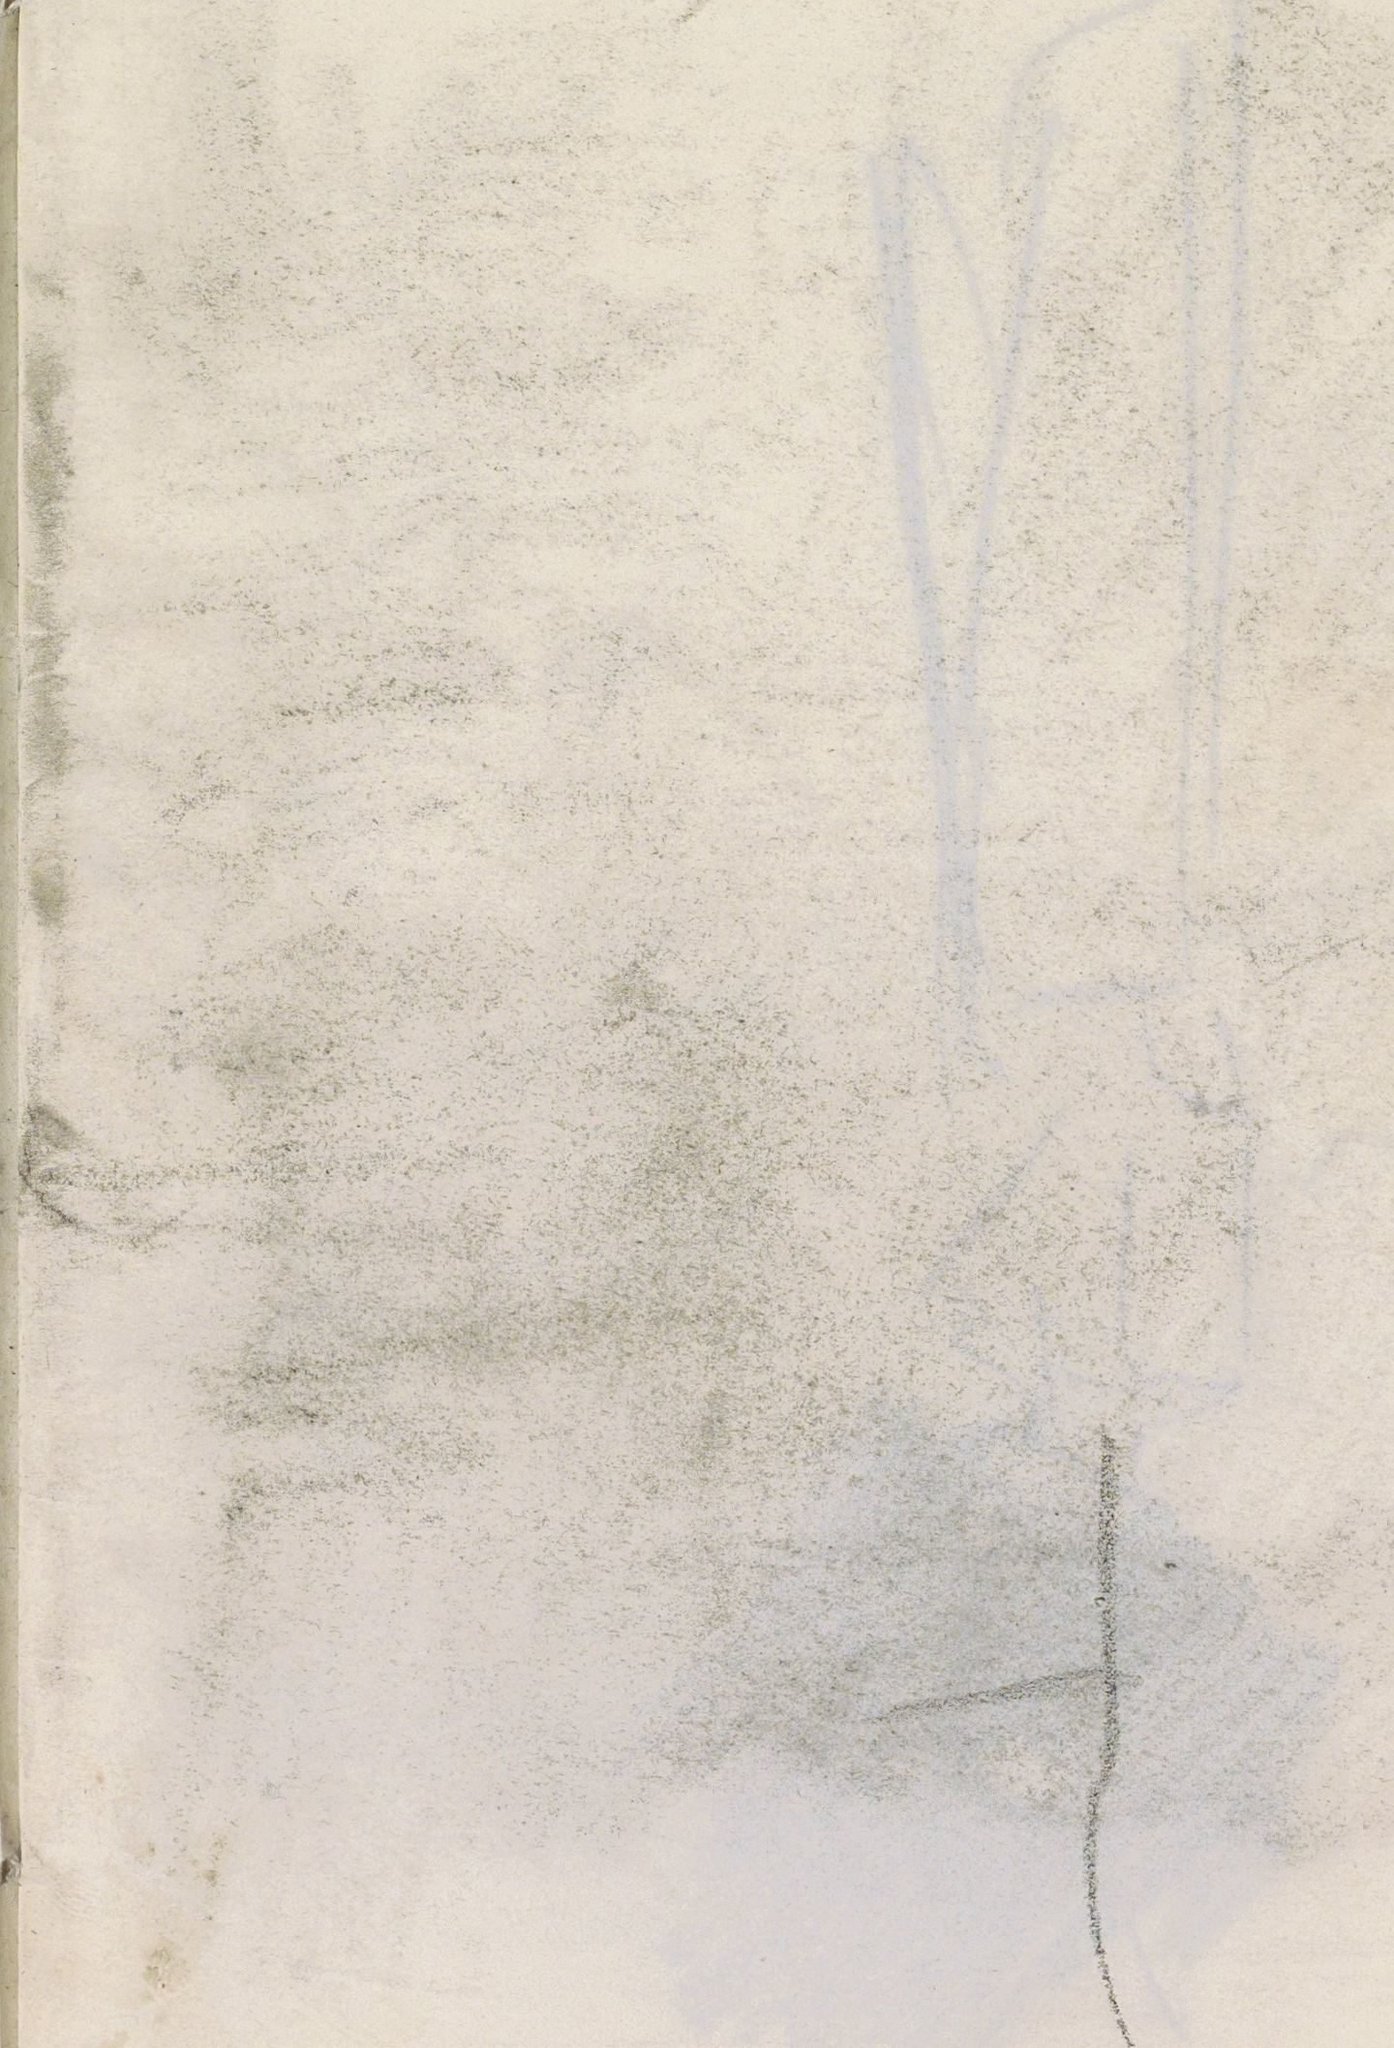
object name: sketchbook leaf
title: Studie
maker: isaac israels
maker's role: draughtsman, painter, print maker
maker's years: 1865-1934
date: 1875-1934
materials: chalk, paper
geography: paris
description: Blad 2 recto uit schetsboek L met 42 bladen.